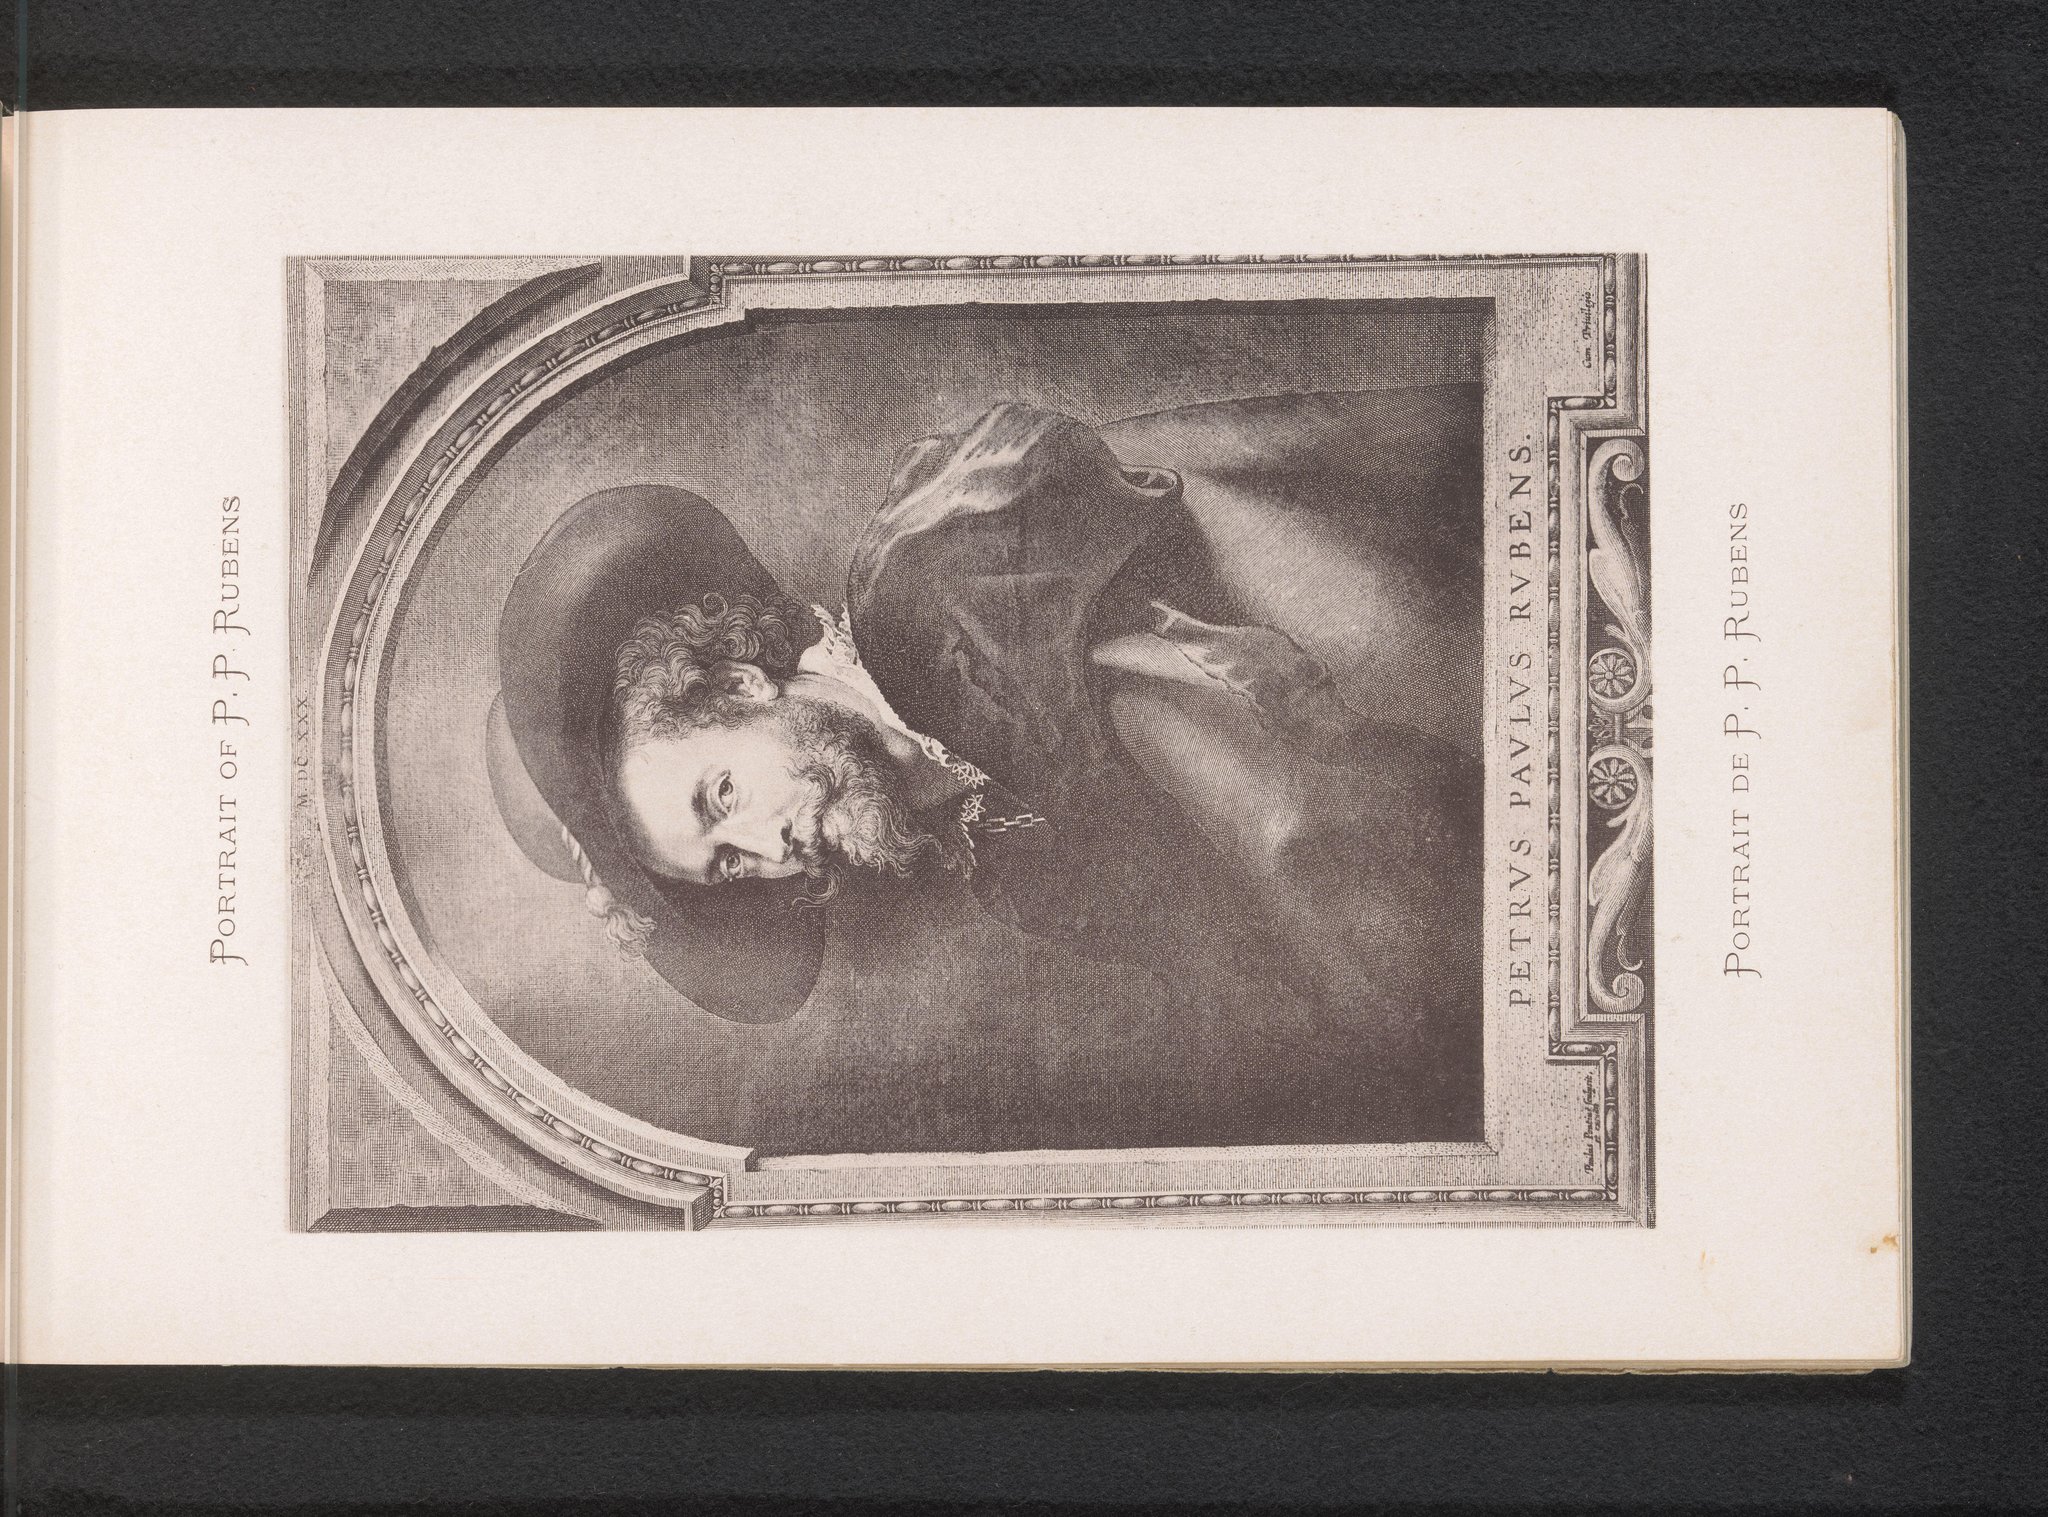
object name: photomechanical print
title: Portrait de P.P. Rubens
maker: Anonymous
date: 1892-1897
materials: paper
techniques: photograph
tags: antwerp, painter, print maker, draughtsman, peter paul rubens, adult man